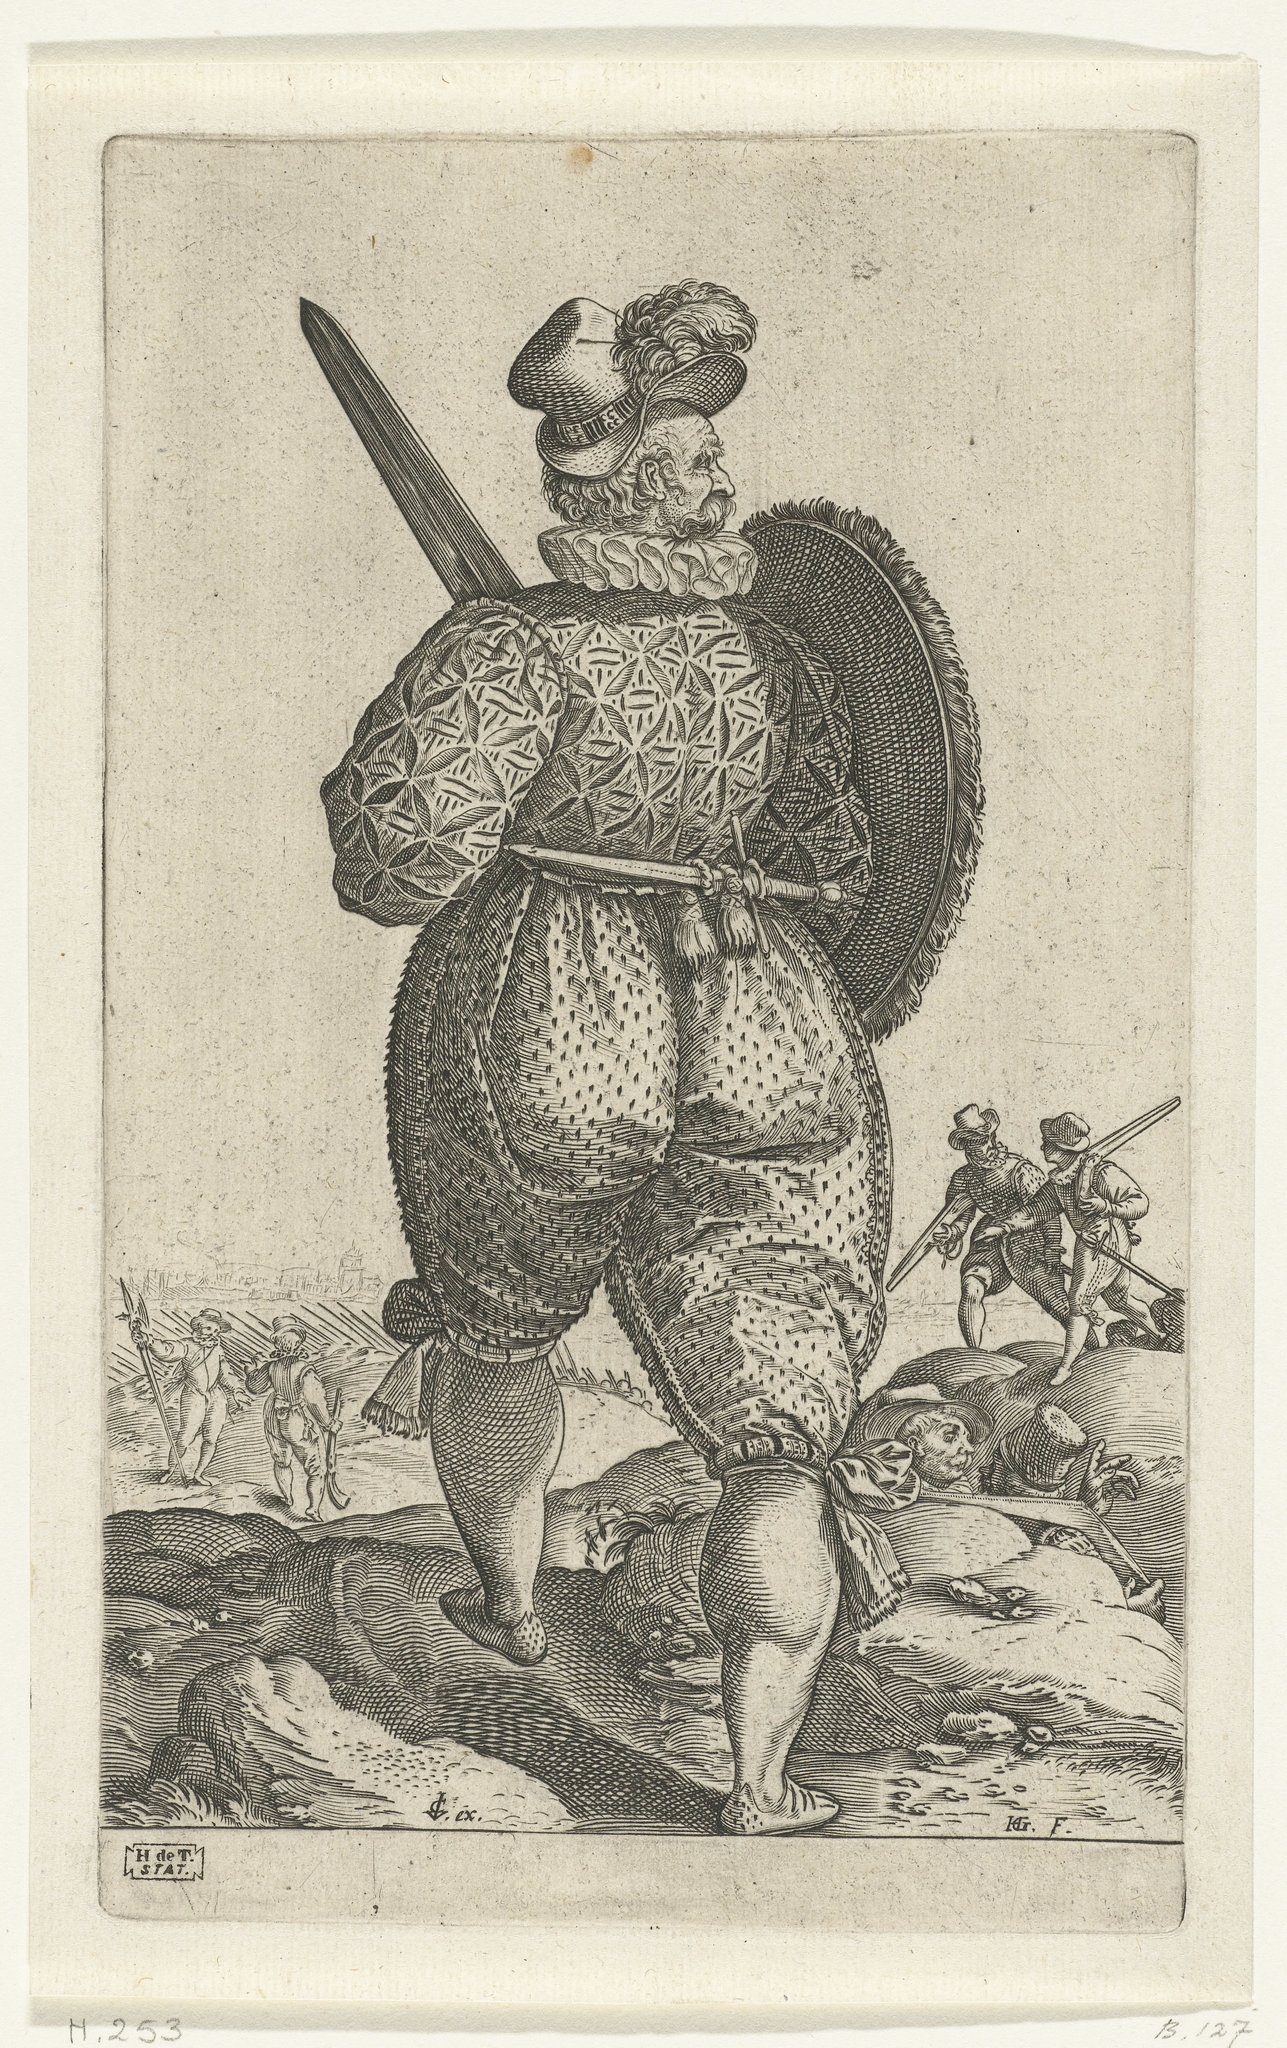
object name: print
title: Een strijder met zwaard, op de rug gezien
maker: hendrick goltzius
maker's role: draughtsman, painter, print maker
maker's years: 1558-1617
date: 1580-1582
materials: paper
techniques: engraving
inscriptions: mark: ‘L.2228.’, address: ‘ICV. ex.’, monogram: ‘HG. F.’, inscription: ‘H de T. Stat.’